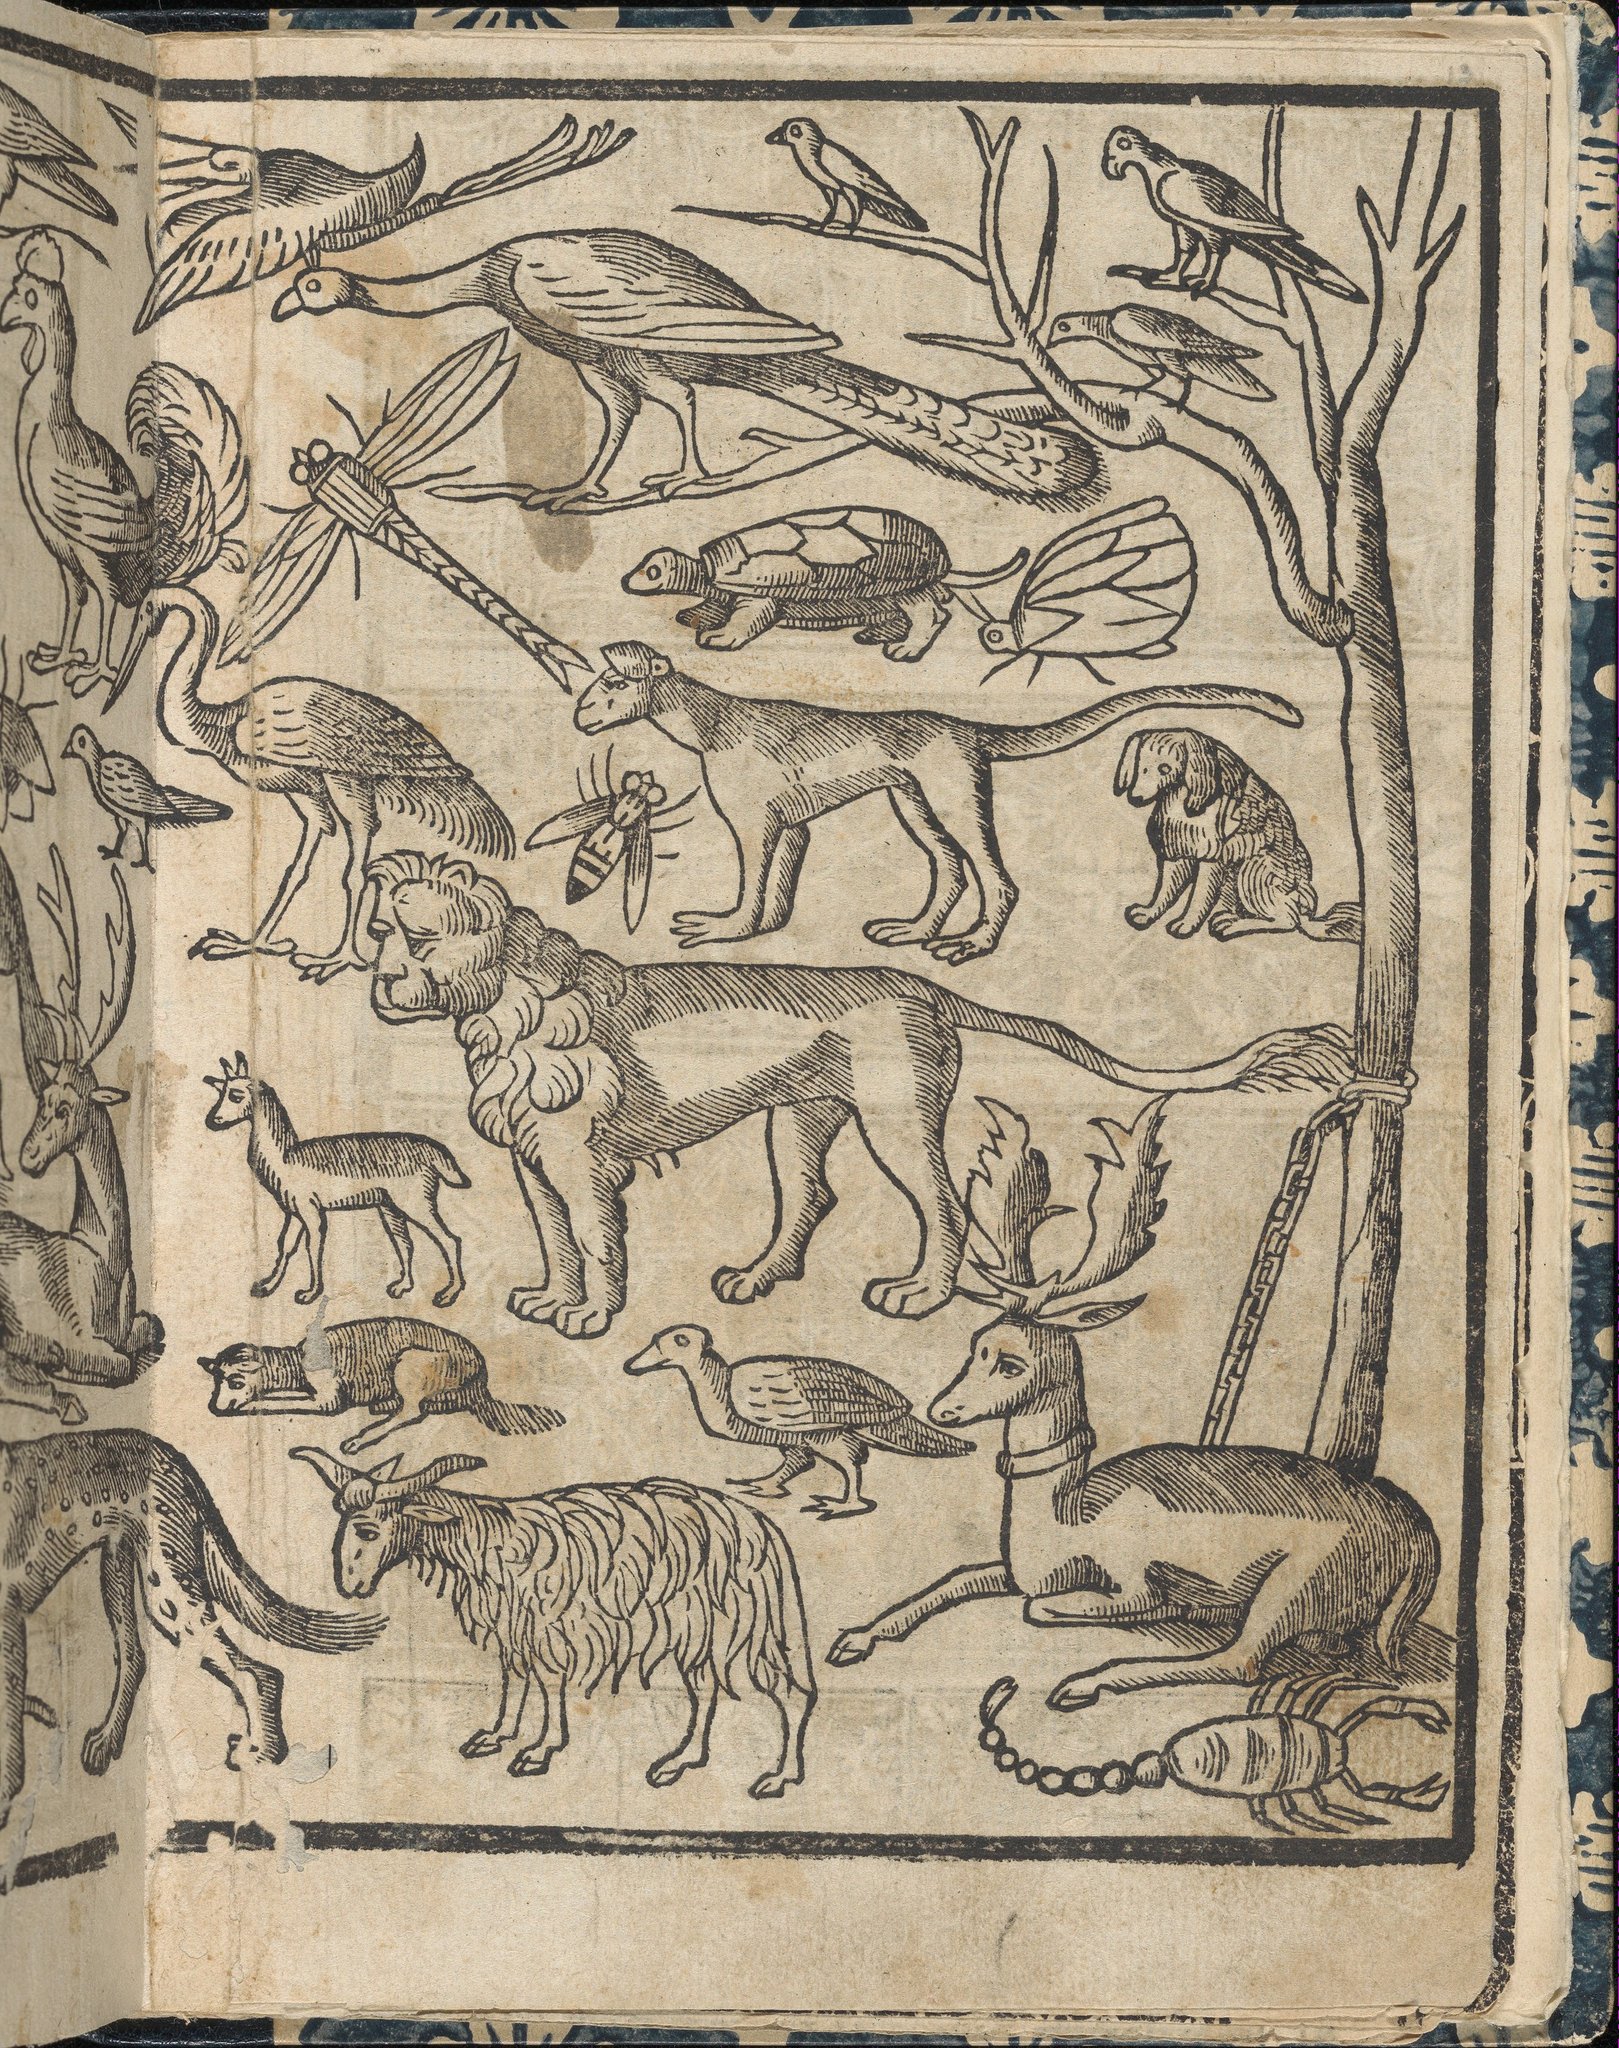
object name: book print ornament architecture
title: Essempio di recammi, page 13 (recto)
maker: giovanni antonio tagliente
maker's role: author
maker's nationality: italian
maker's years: 1465-1528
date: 1530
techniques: woodcut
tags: birds,roosters,deer,insects,lions